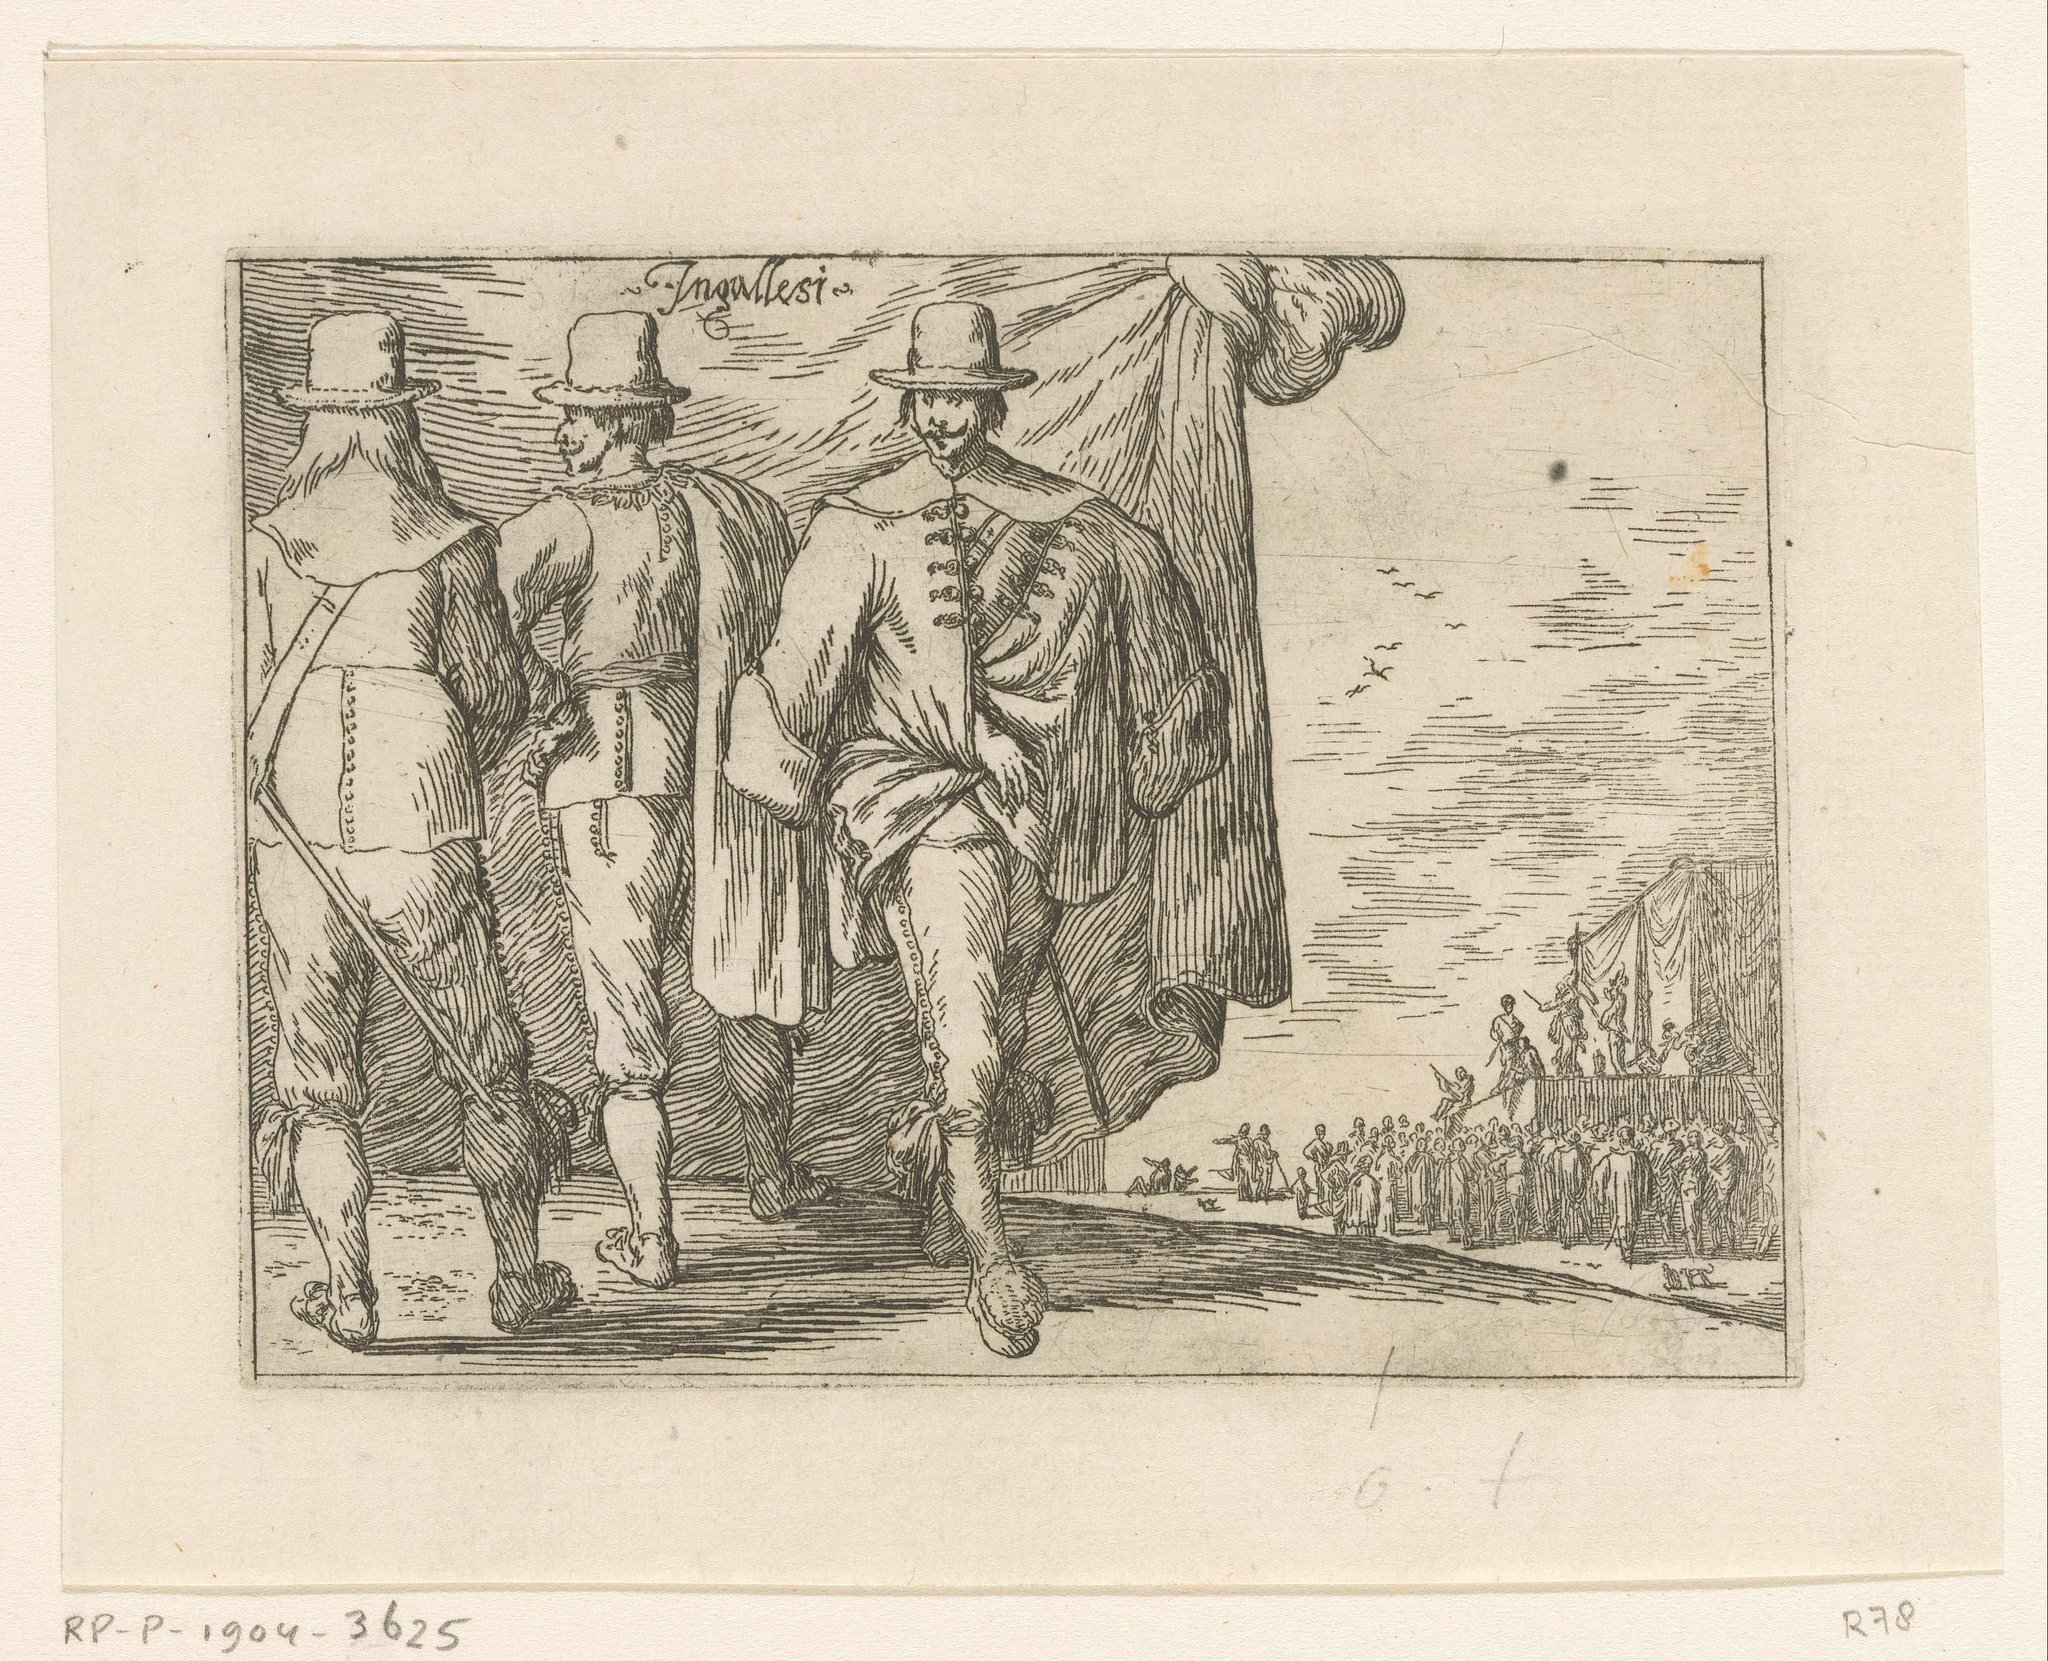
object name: print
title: Klederdrachten van verschillende volkeren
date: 1636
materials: paper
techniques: etching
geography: rome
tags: buildings for performances - aa - open-air performances, europeans: englishmen (+ costume), clothes, costume (+ men's clothes)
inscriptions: collector's mark: Lugt 2228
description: Eerste prent uit de serie 'Klederdrachten van verschillende volkeren', bestaand uit vijftien prenten en een titelprent.